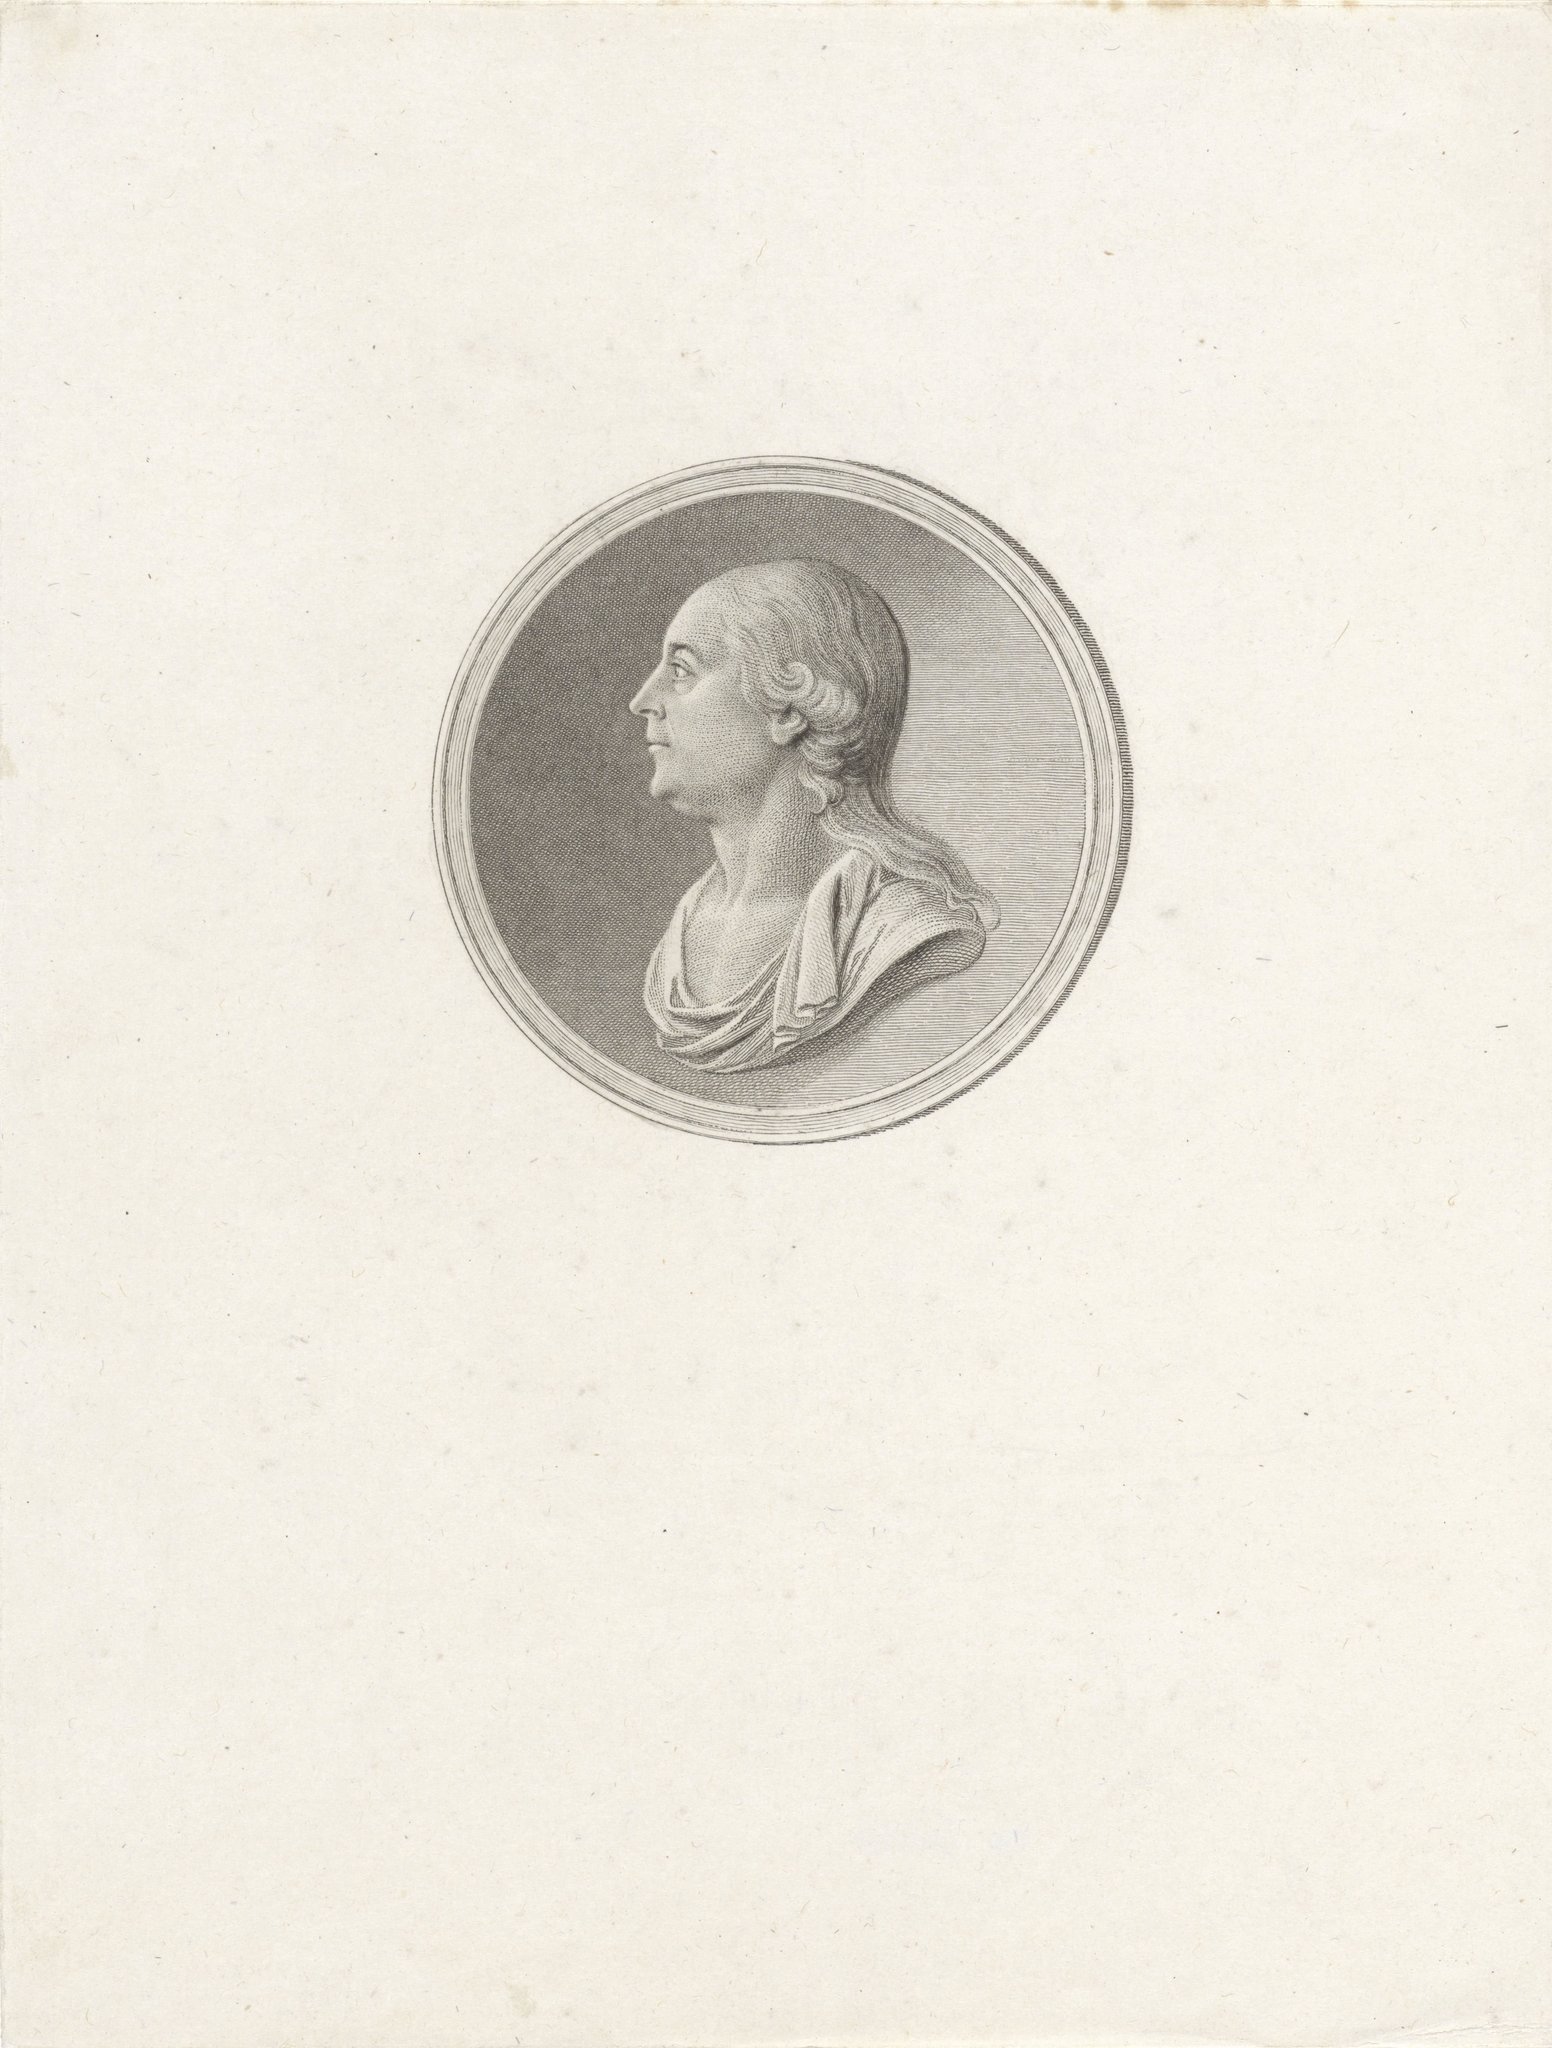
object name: print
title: Portret van Jan Hendrik van Kinsbergen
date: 1806-1816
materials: paper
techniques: etching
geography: amsterdam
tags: jonkheer jan hendrik van kinsbergen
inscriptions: collector's mark: Lugt 240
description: Portret van de Nederlandse admiraal Jan Hendrik van Kinsbergen, als antieke buste.